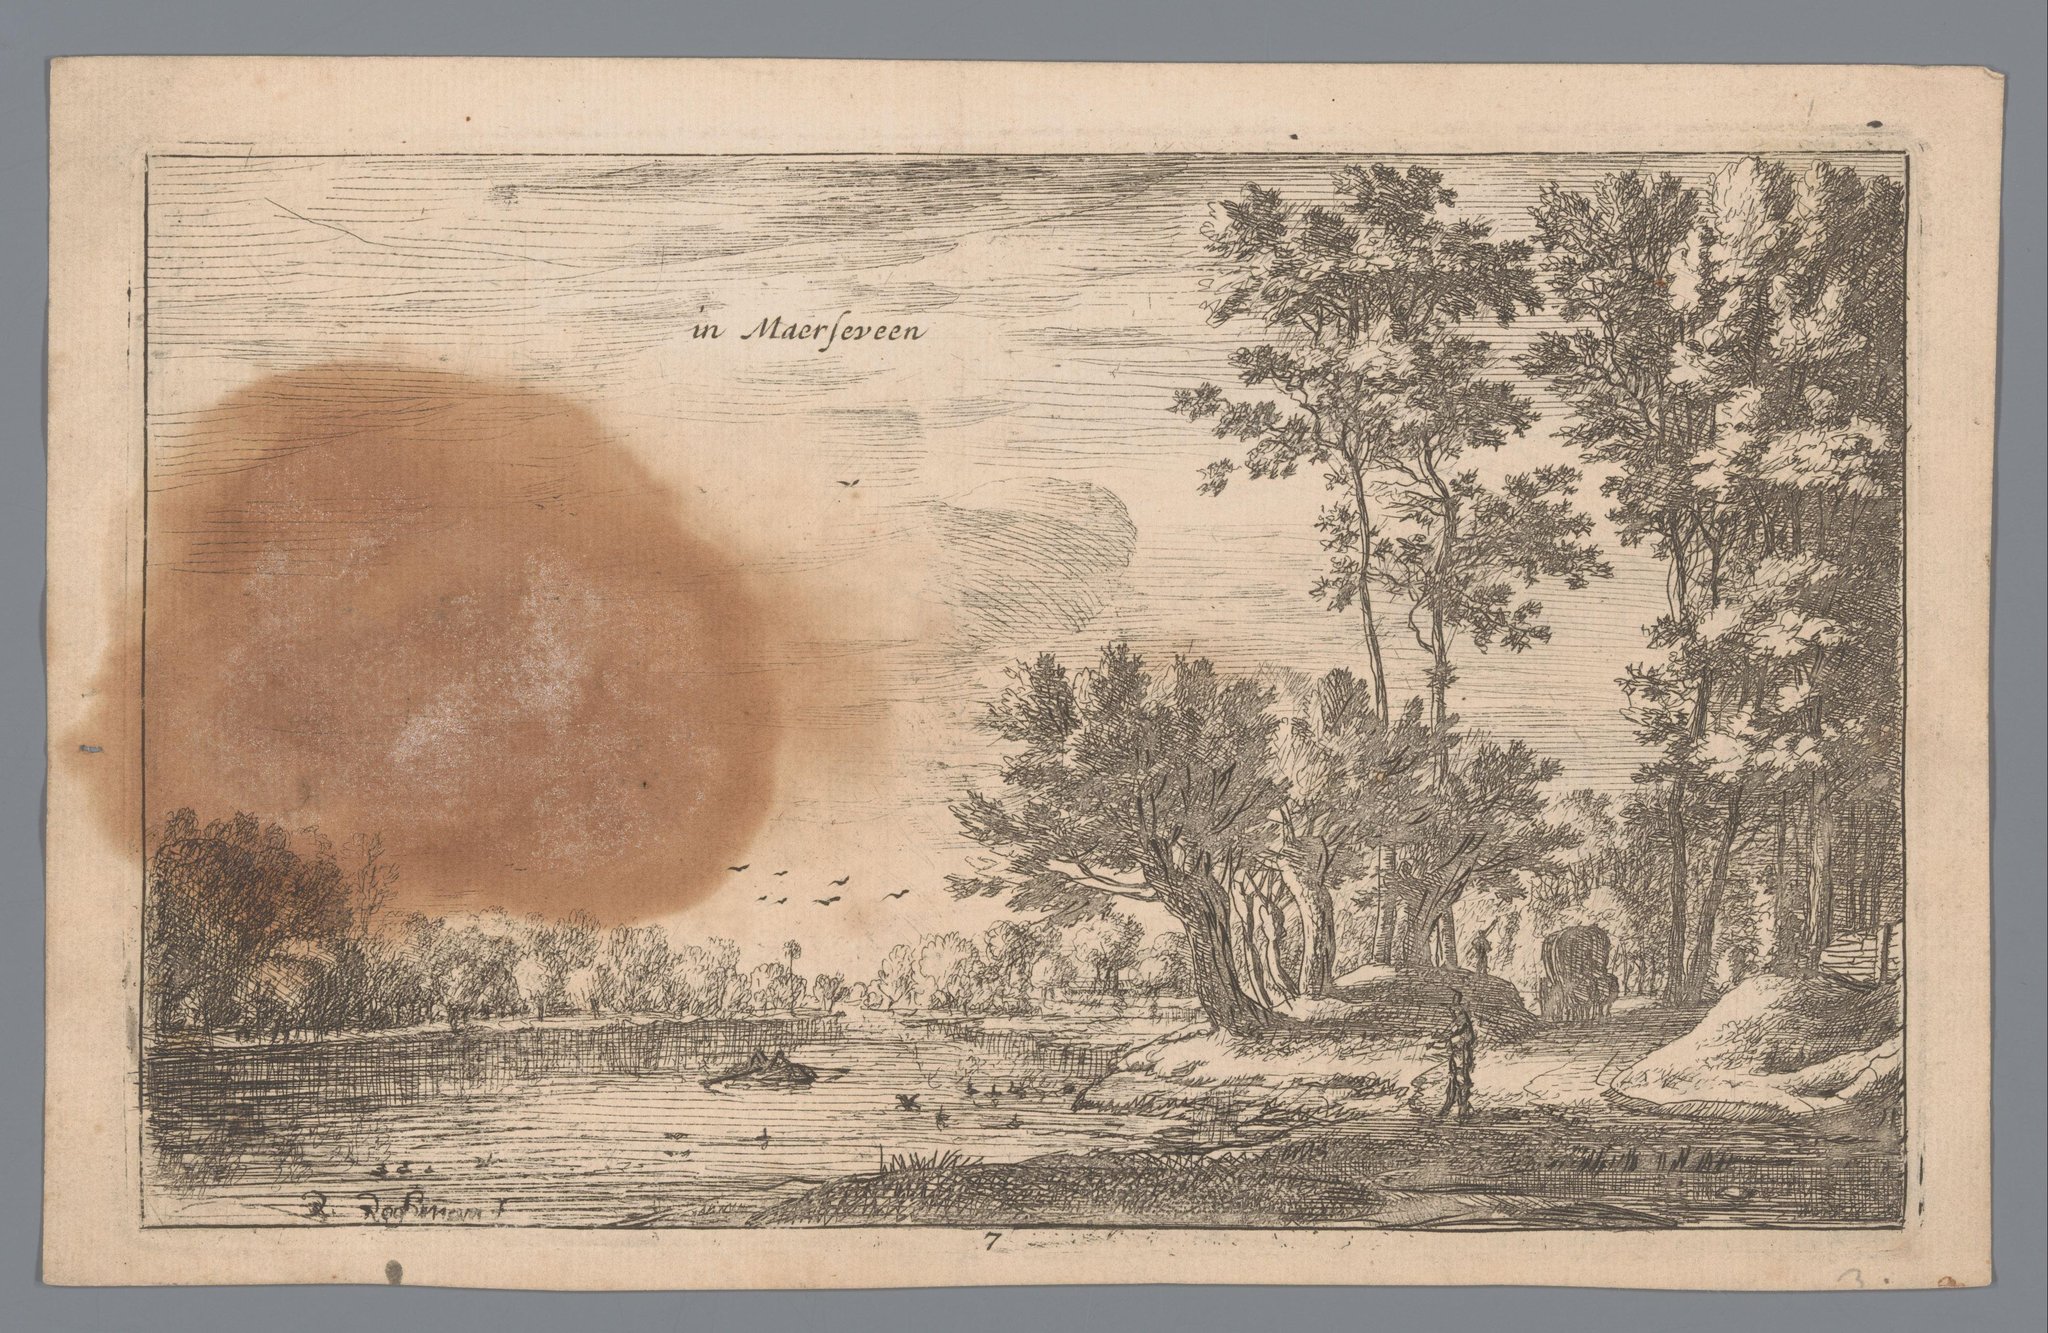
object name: print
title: Riviergezicht bij Maarsseveen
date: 1637-1677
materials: paper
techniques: drypoint, etching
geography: amsterdam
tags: river, rowing-boat, canoe, etc., fisherman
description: Gezicht op rivier de Vecht bij het dorp Maarsseveen. Aan de waterkant heeft een visser zijn hengel uitgegooid. Op de Vecht een roeiboot en aan de oever een slingerpad met een rijtuig. Genummerd onderaan in de marge: 7.